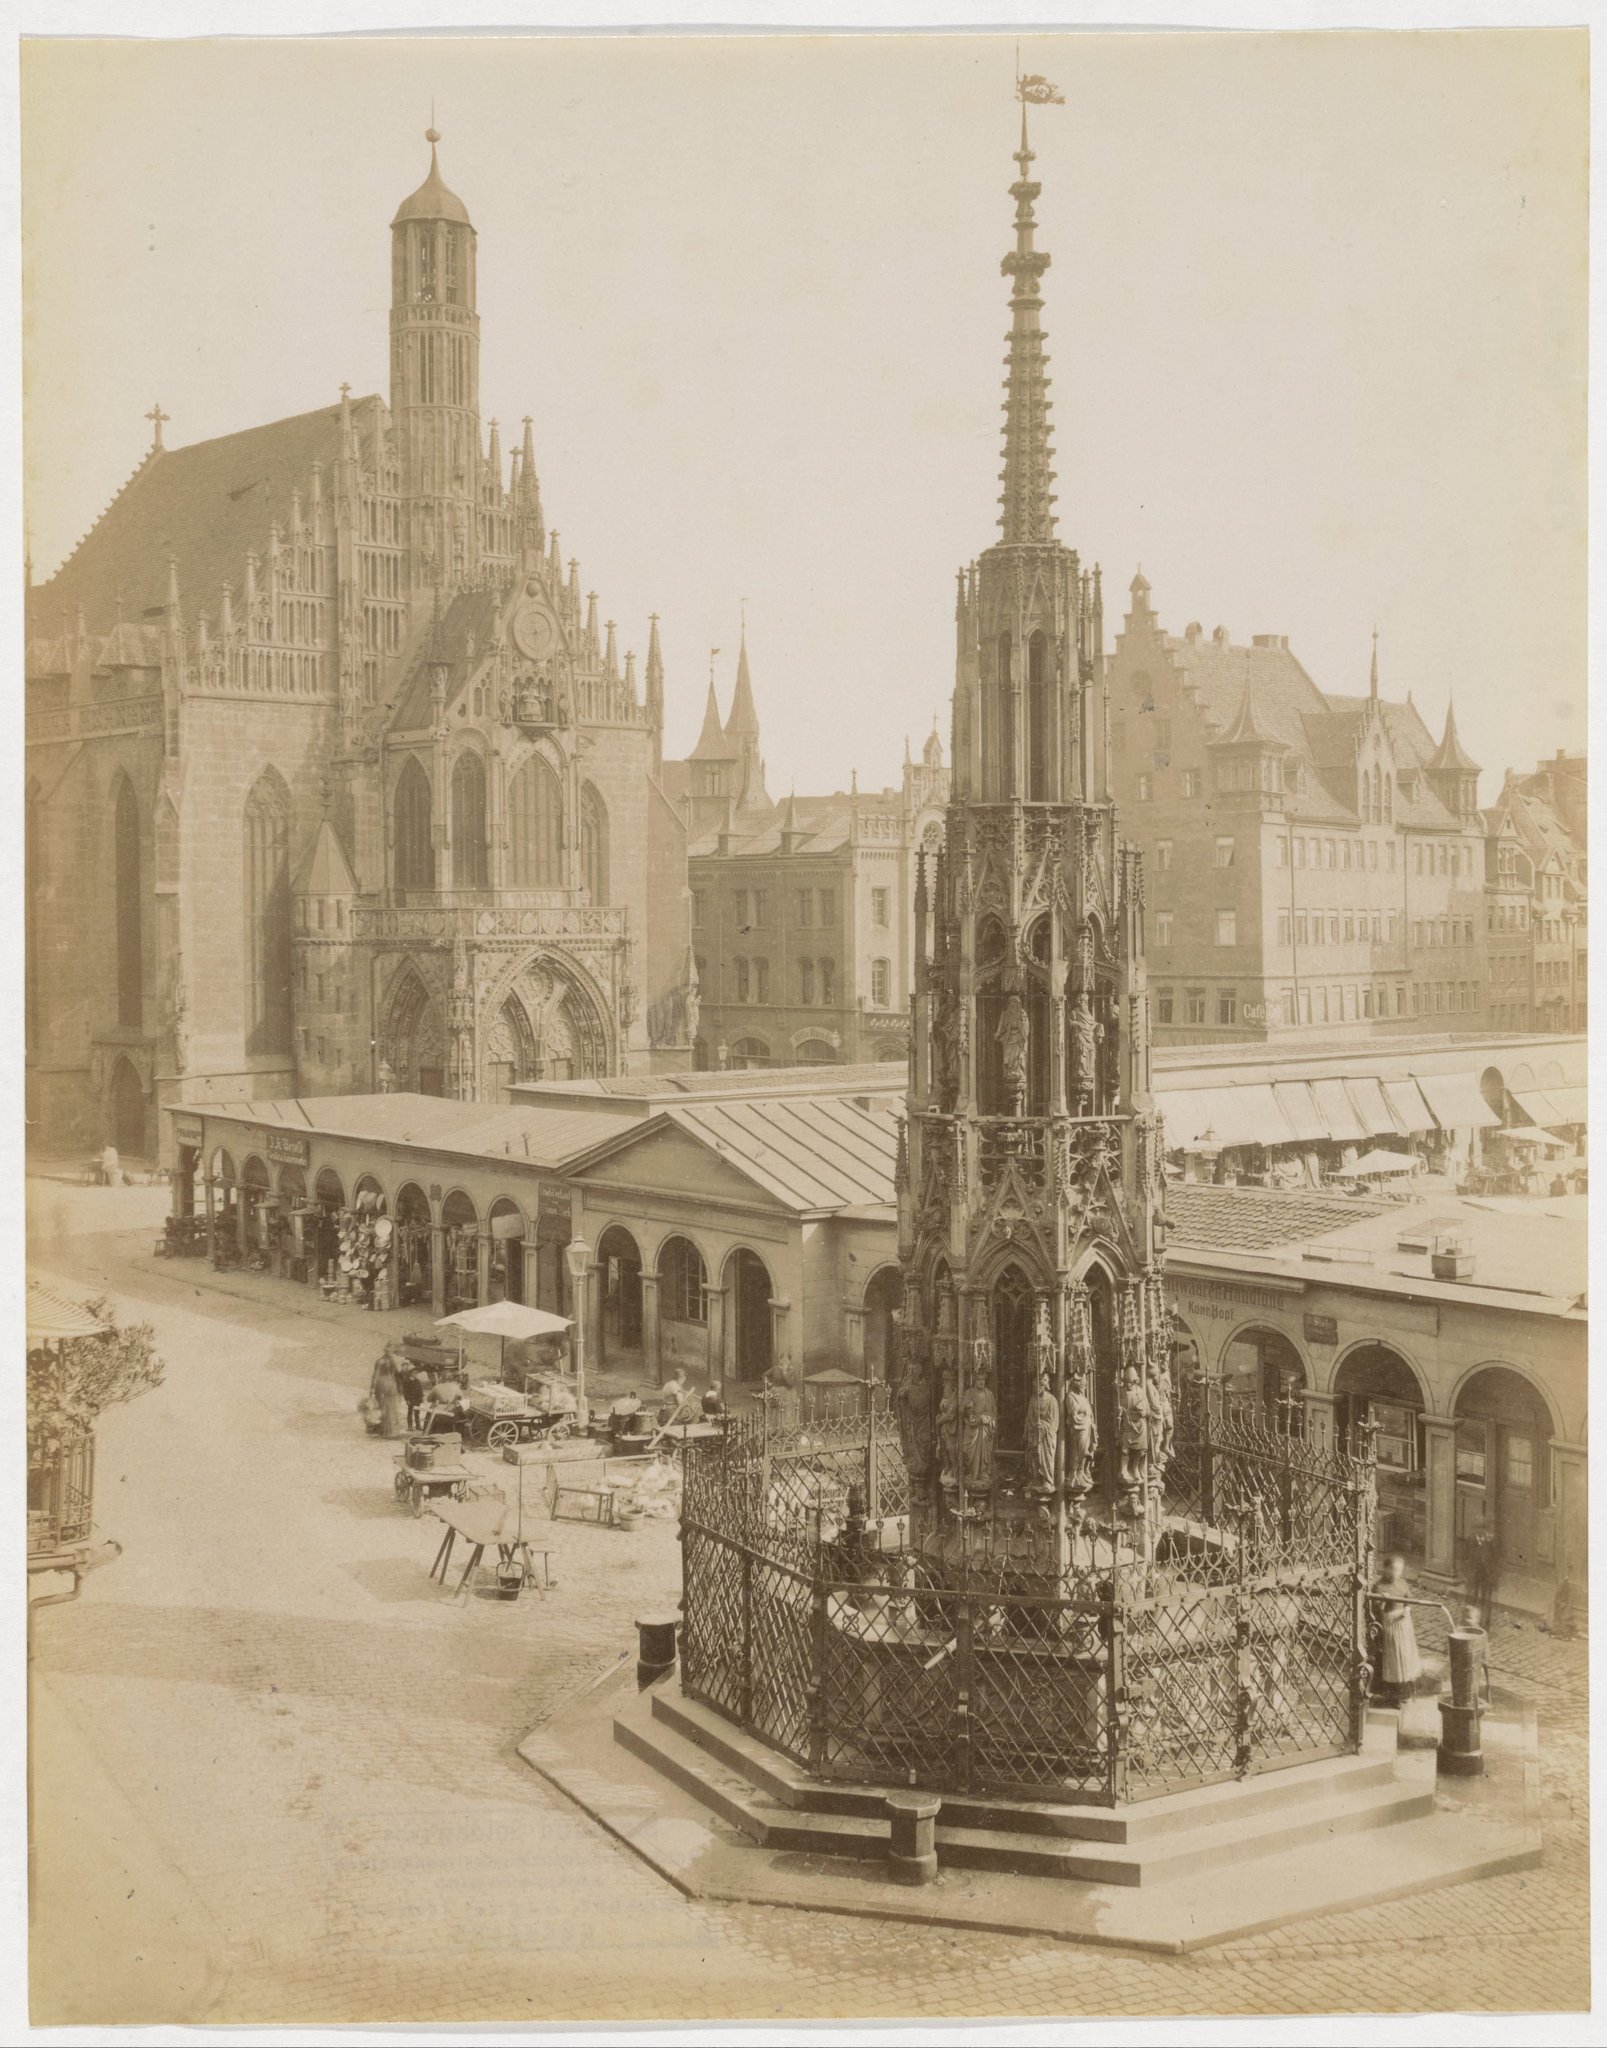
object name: photograph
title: Schöner Brunnen II, Nürnberg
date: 1870-1895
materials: paper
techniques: albumen print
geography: nuremberg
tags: ornamental fountain, market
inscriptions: number: ‘113.’, stamp: ‘Sigmund Soldan'sche/ Hof-Buch-Kunst & Musikalienhandlung/ Musikalienleihanstalt/ Inhaber: August Zemsch/ Nürnberg.’